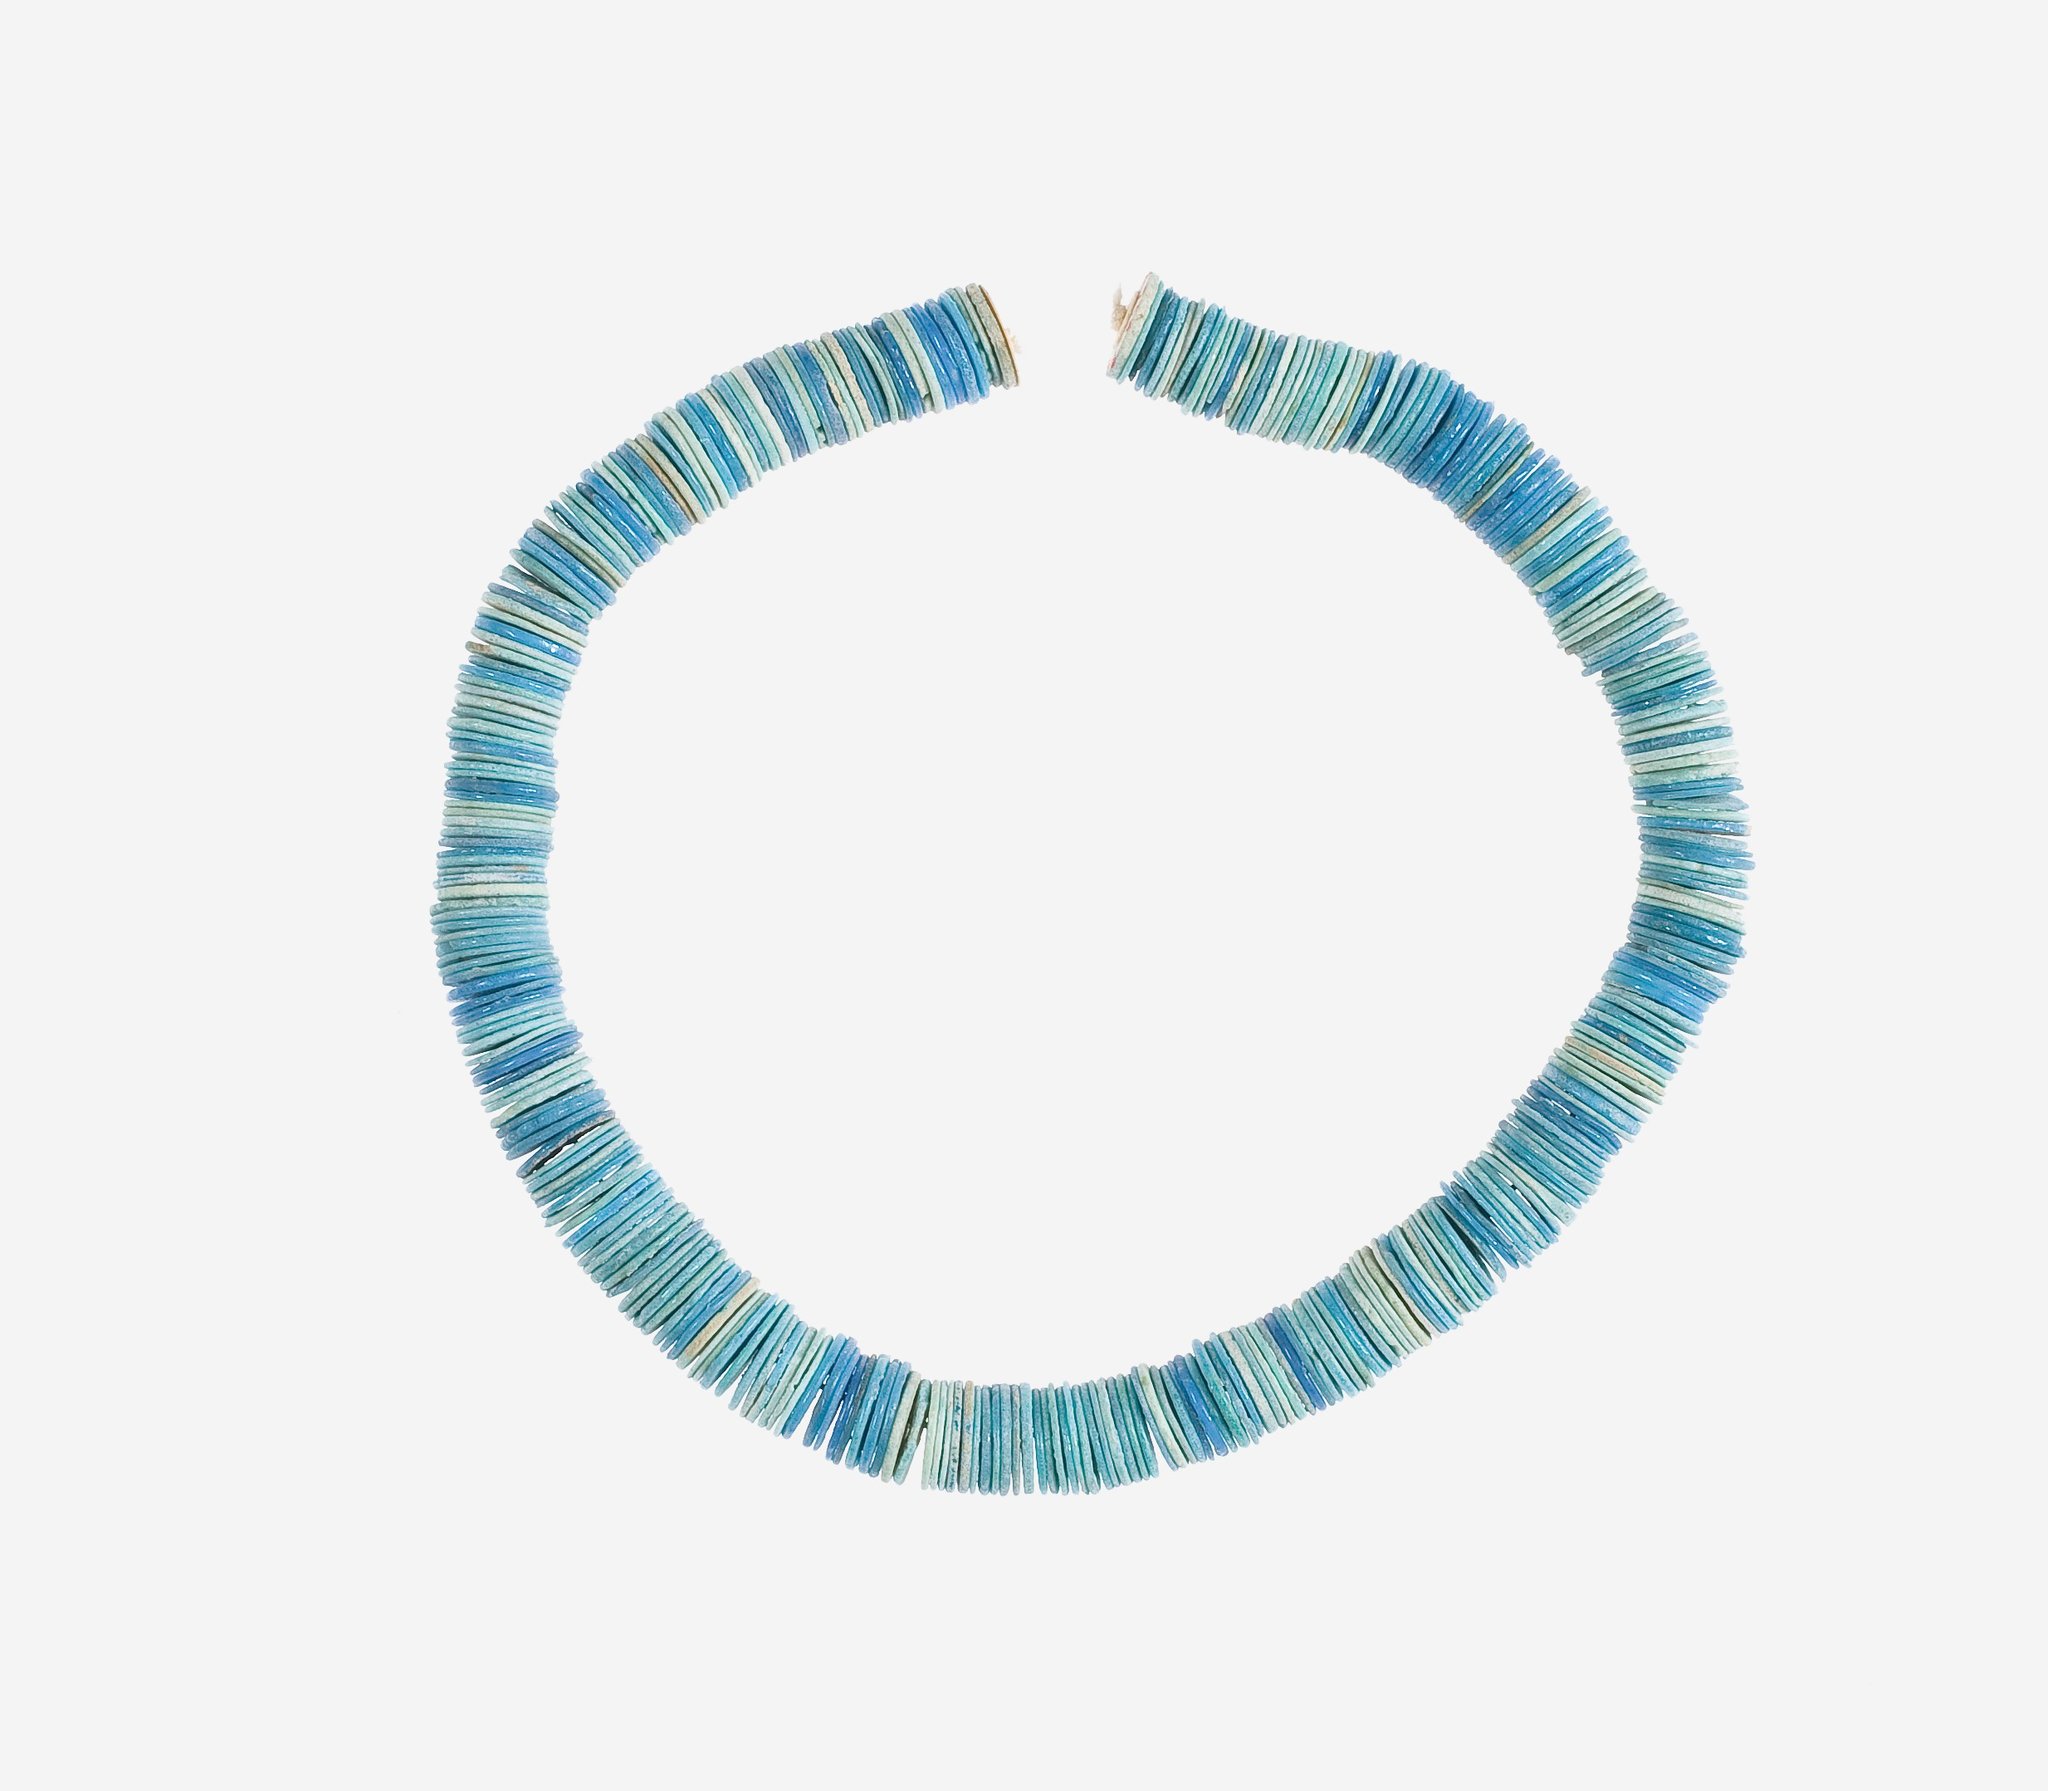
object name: bead, disk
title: String of Large Flat Disk Beads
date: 1390-1352 BCE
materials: faience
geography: egypt